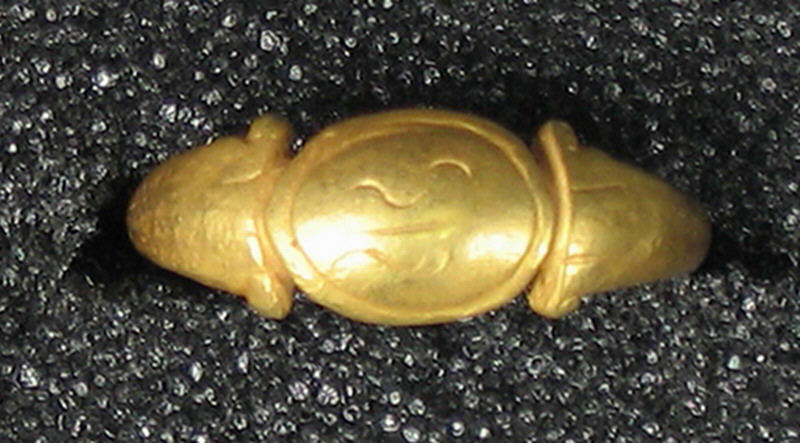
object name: ring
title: Ring wirh Round Bezel, Javanese Calligraphy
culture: indonesian, central java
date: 701-1200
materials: gold